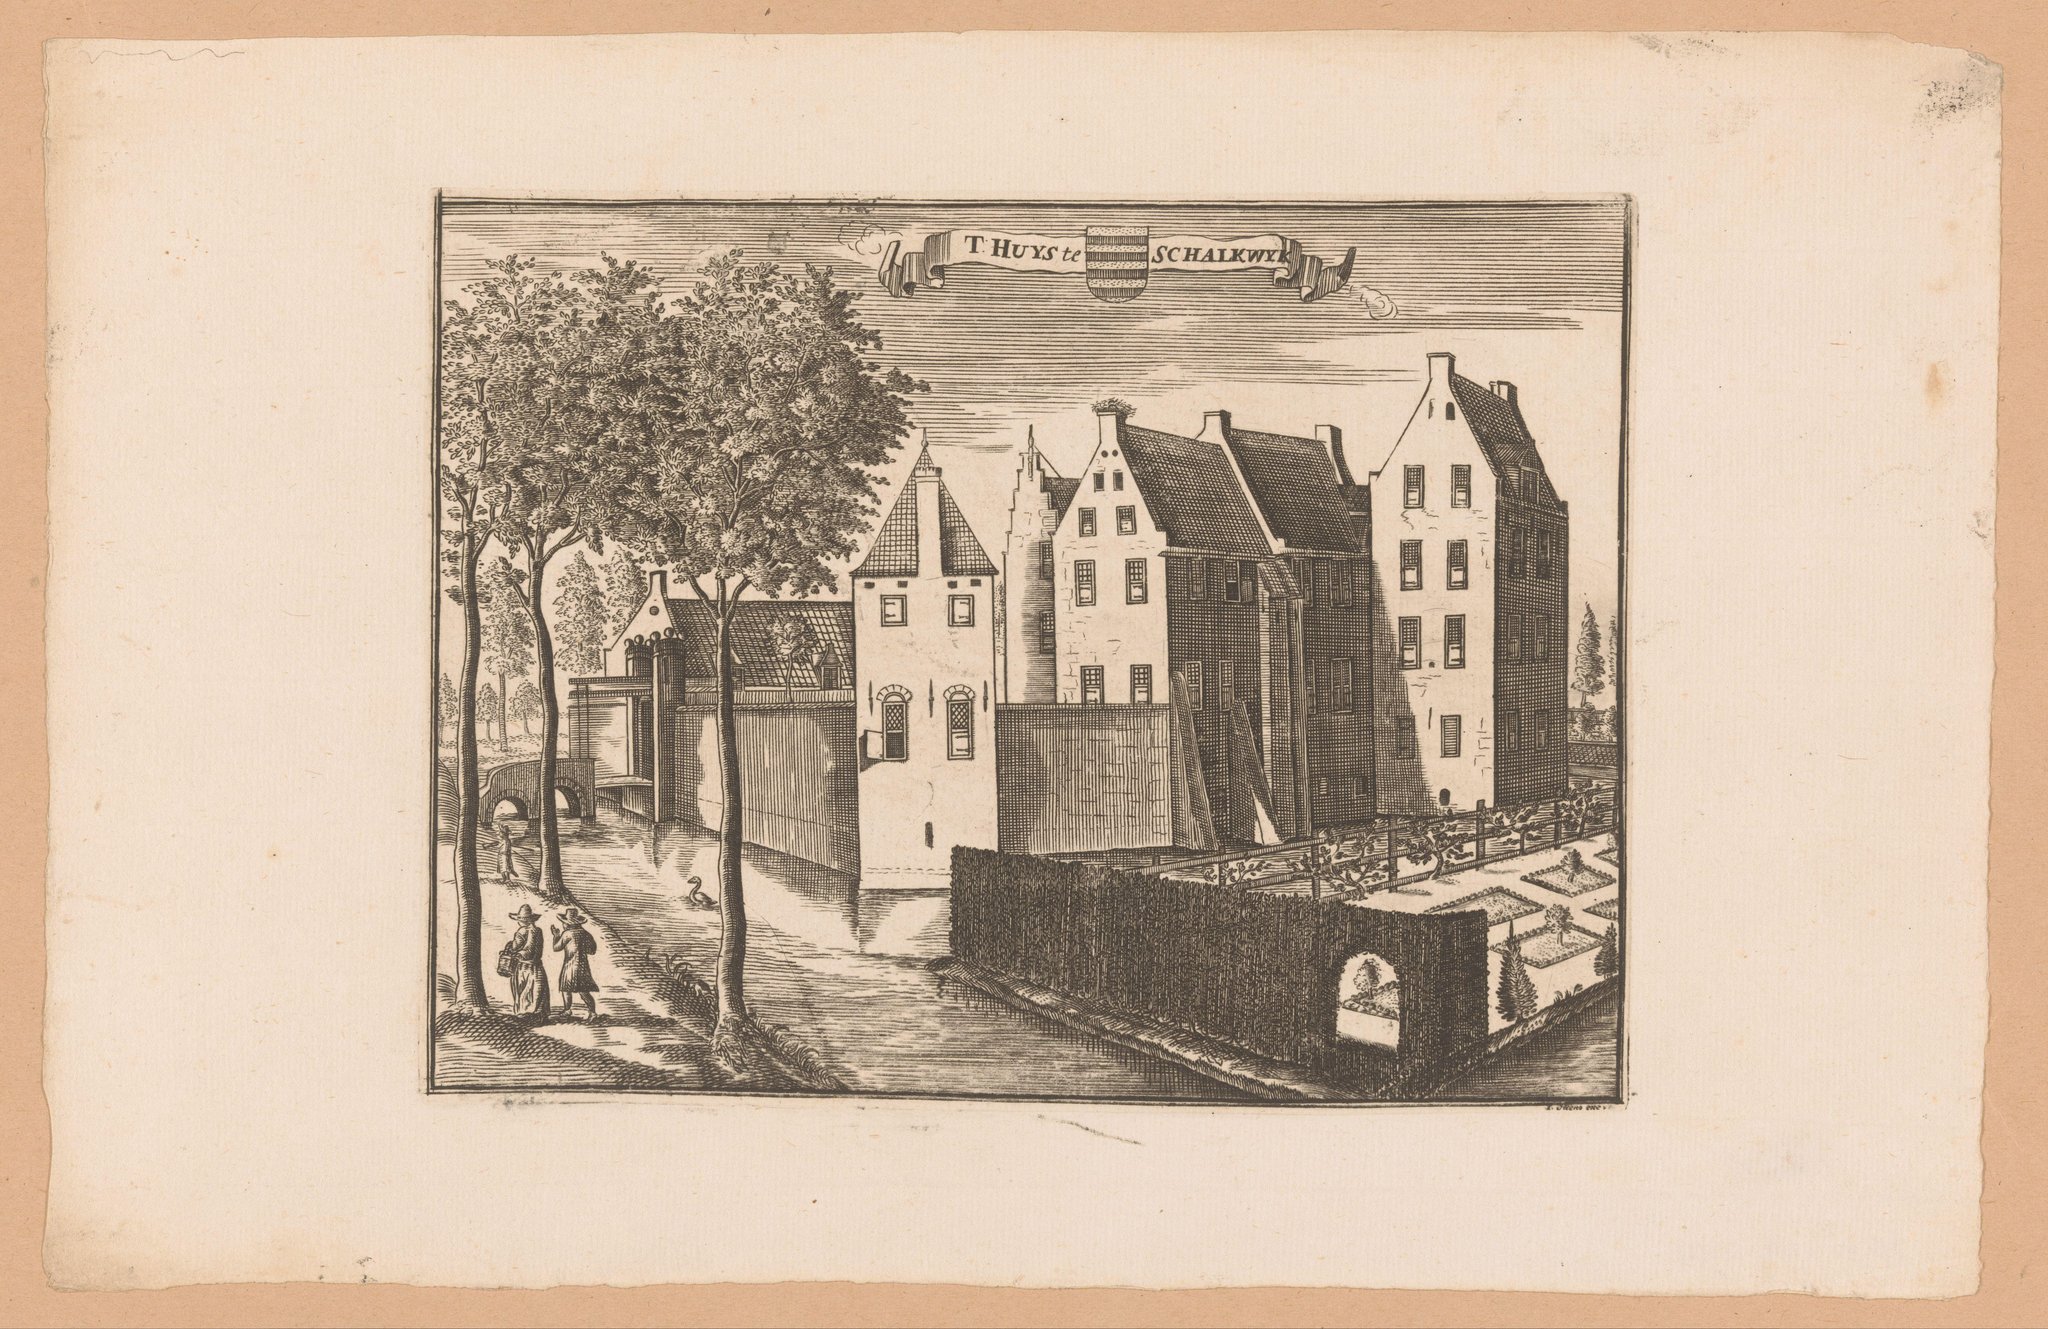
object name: print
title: Gezicht op kasteel Schalkwijk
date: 1710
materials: paper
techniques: engraving, etching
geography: utrecht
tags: castle, landscape with tower or castle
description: Prent uit: De Ridder-matige Huysen en Gesichten in de Provincie van Utrecht. Amsterdam: Joachim Ottens, [ca. 1710].